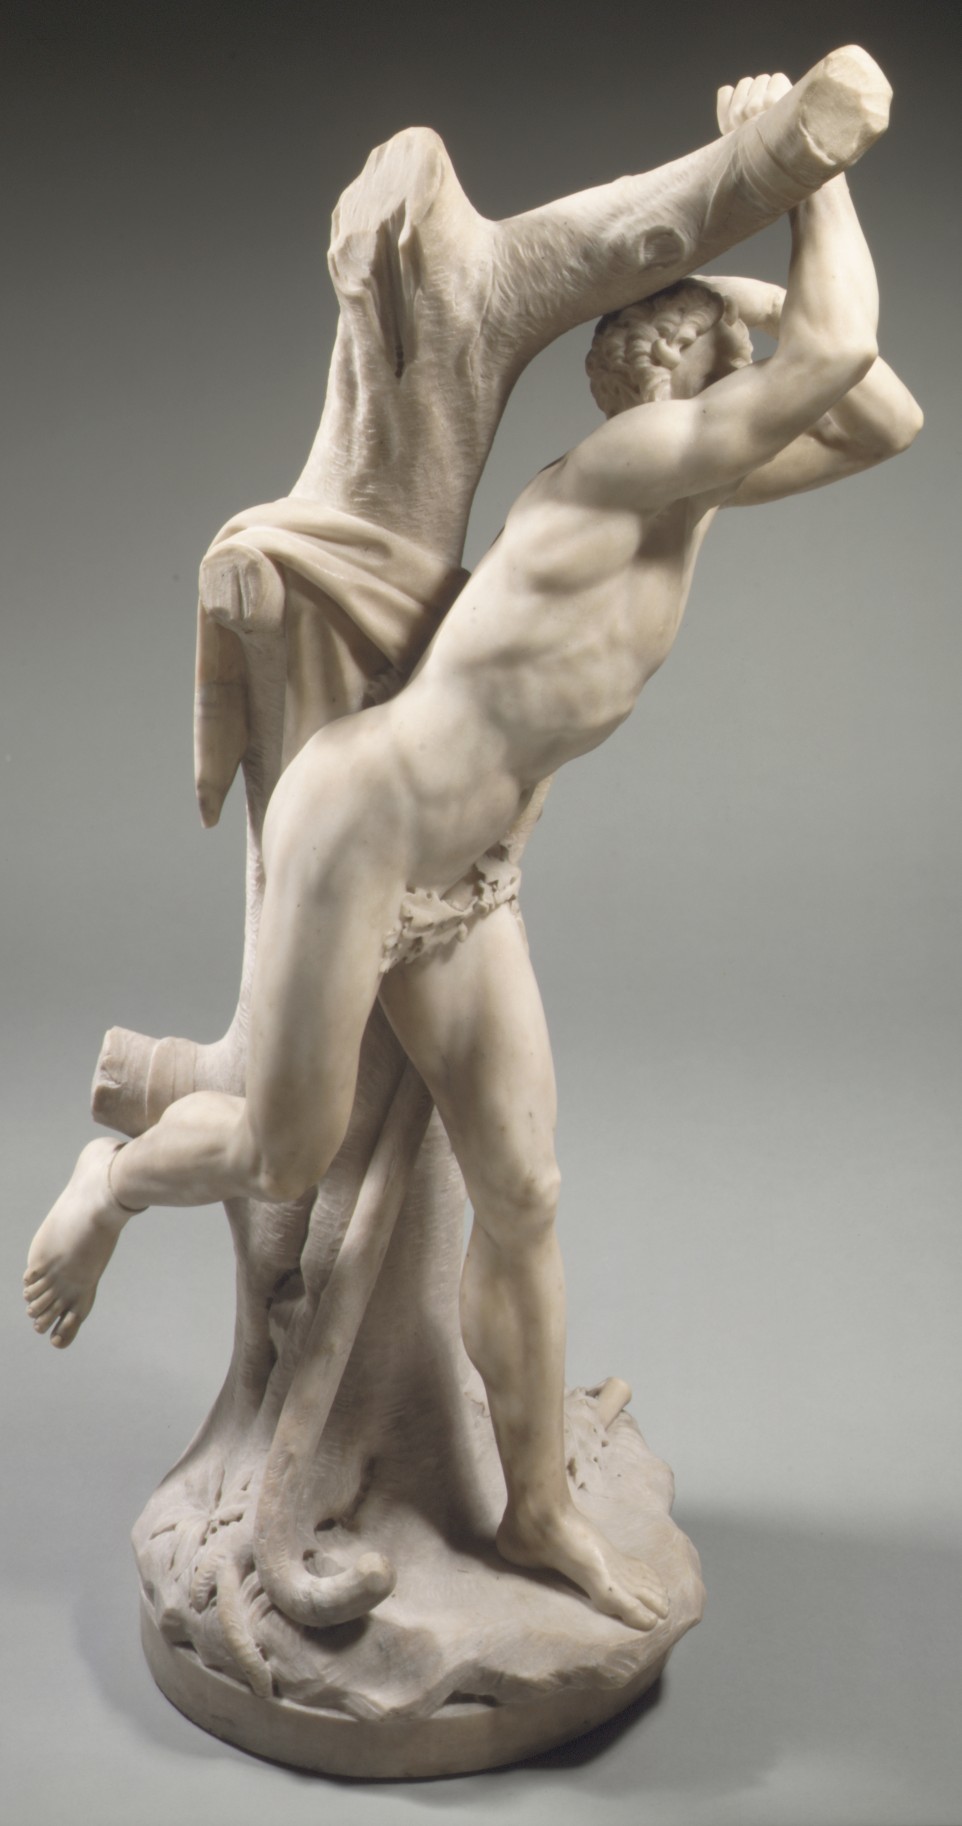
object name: statue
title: Marsyas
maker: christophe veyrier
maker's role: artist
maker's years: 1637-1689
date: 1651-1700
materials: marble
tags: satyrs